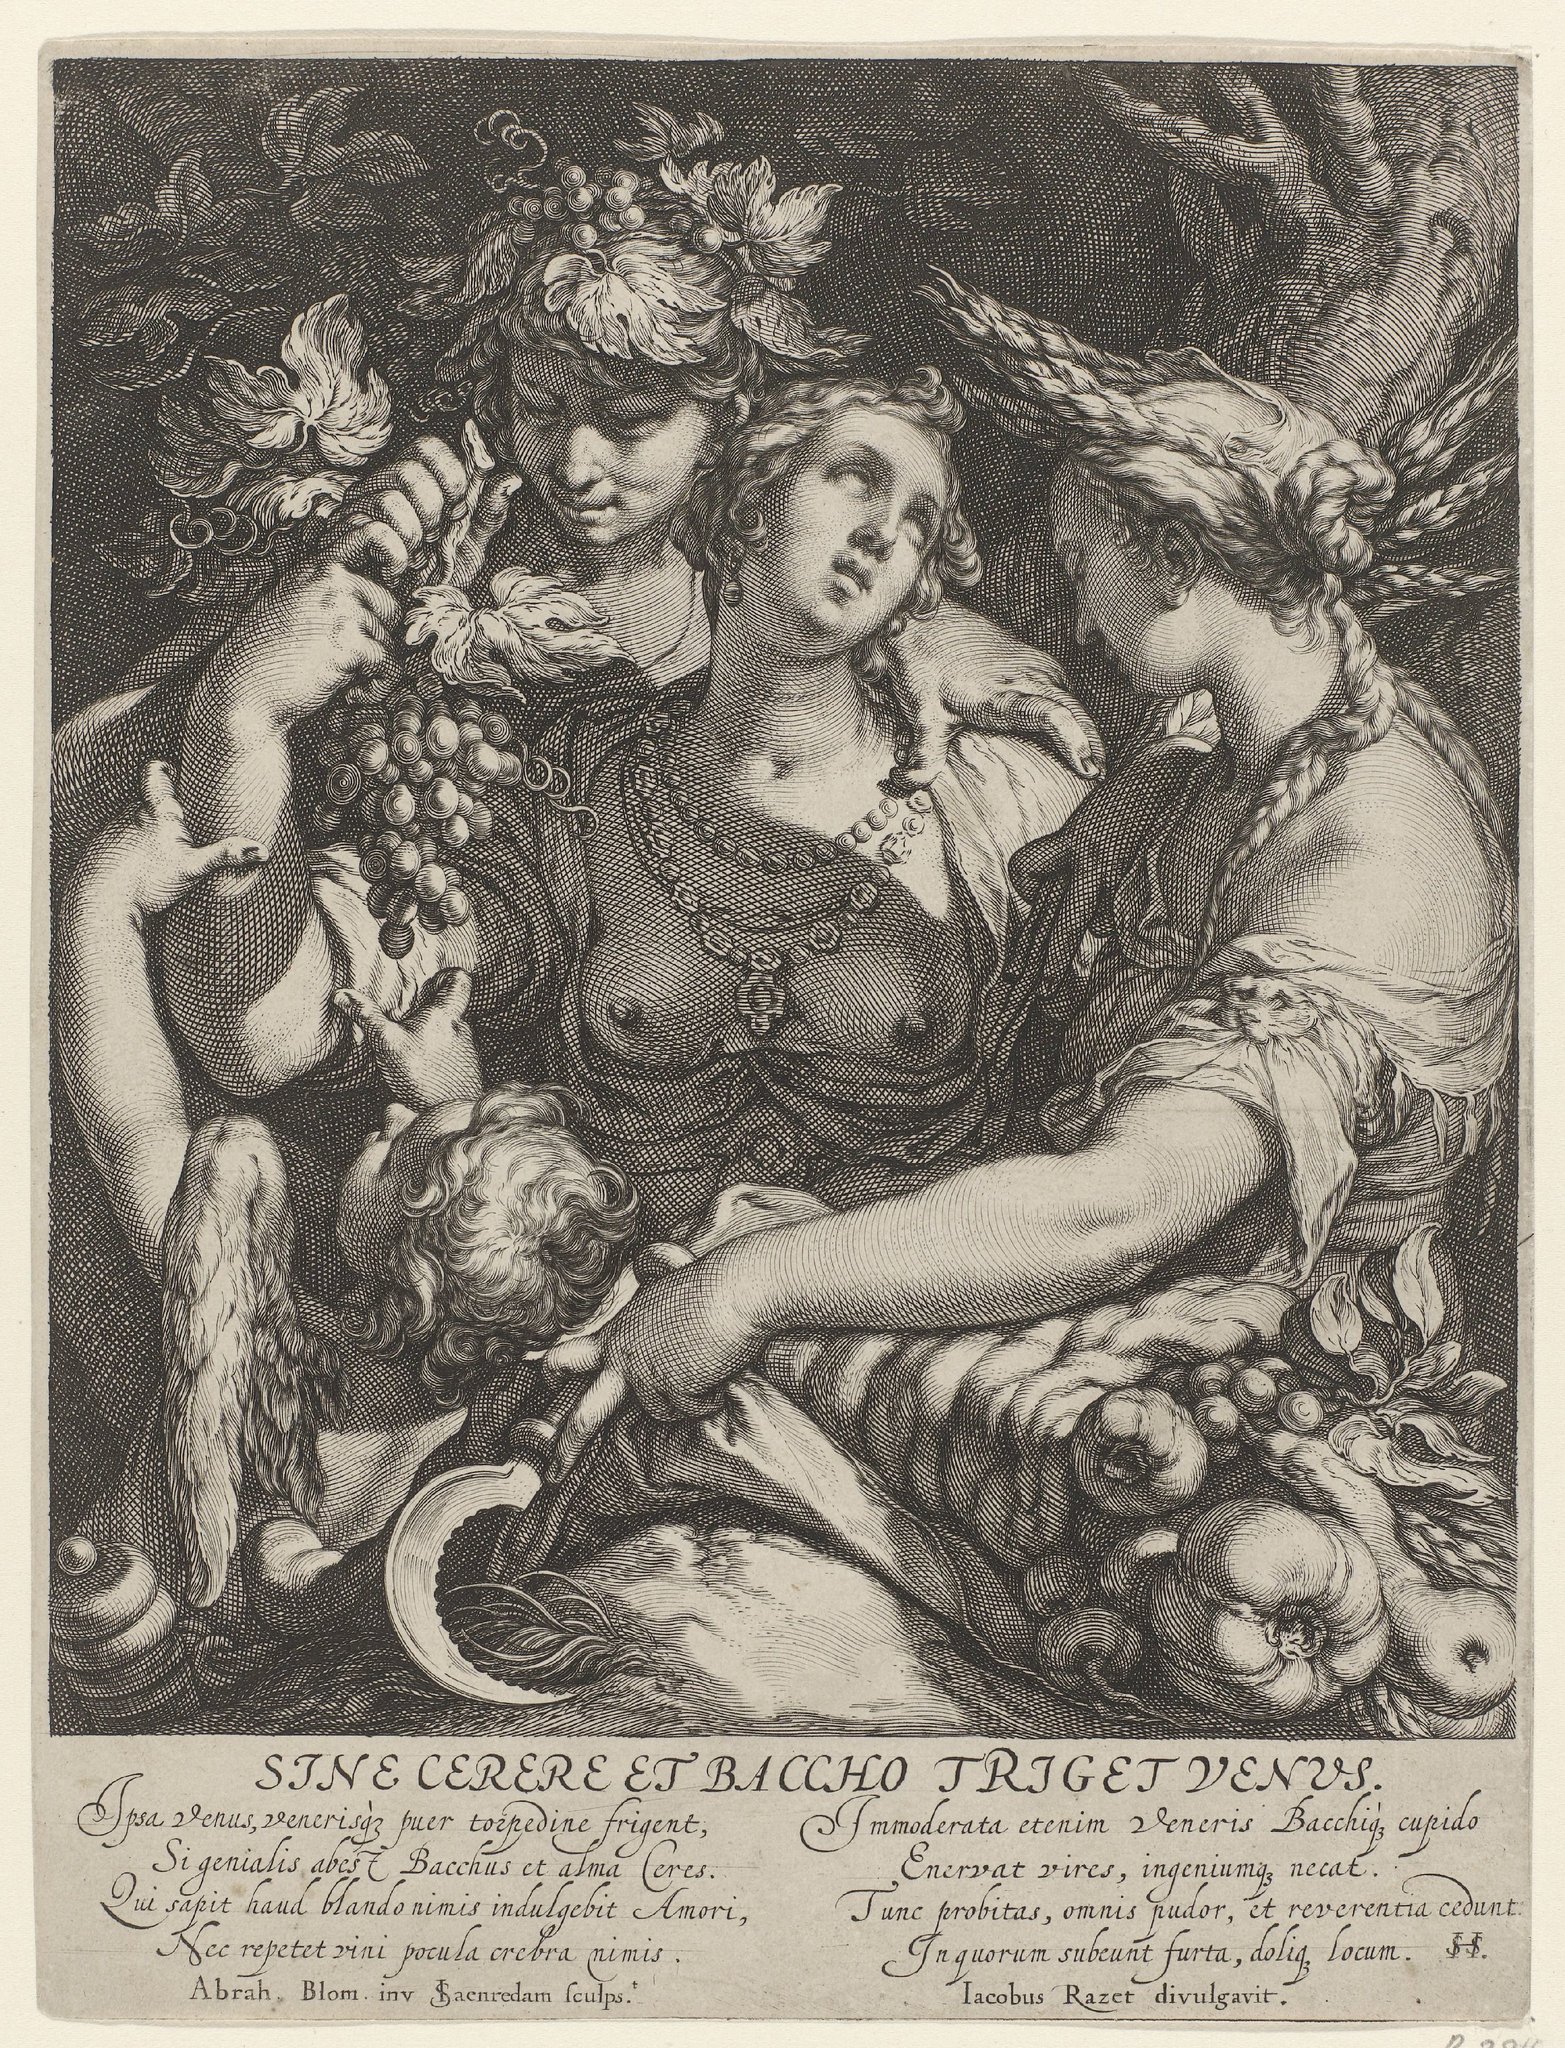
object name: print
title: Sine Cerere et Baccho friget Venus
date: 1575-1607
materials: paper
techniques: engraving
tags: 'sine cerere et baccho friget venus'